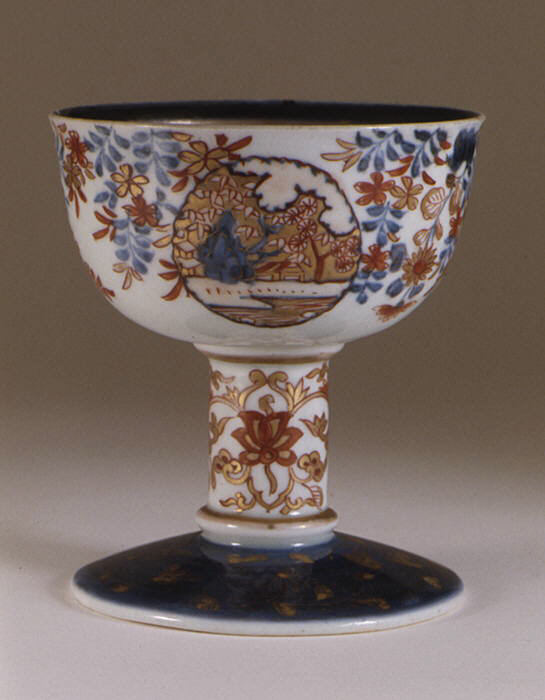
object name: cup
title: Footed cup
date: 1701-1733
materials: hard paste porcelain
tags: flowers